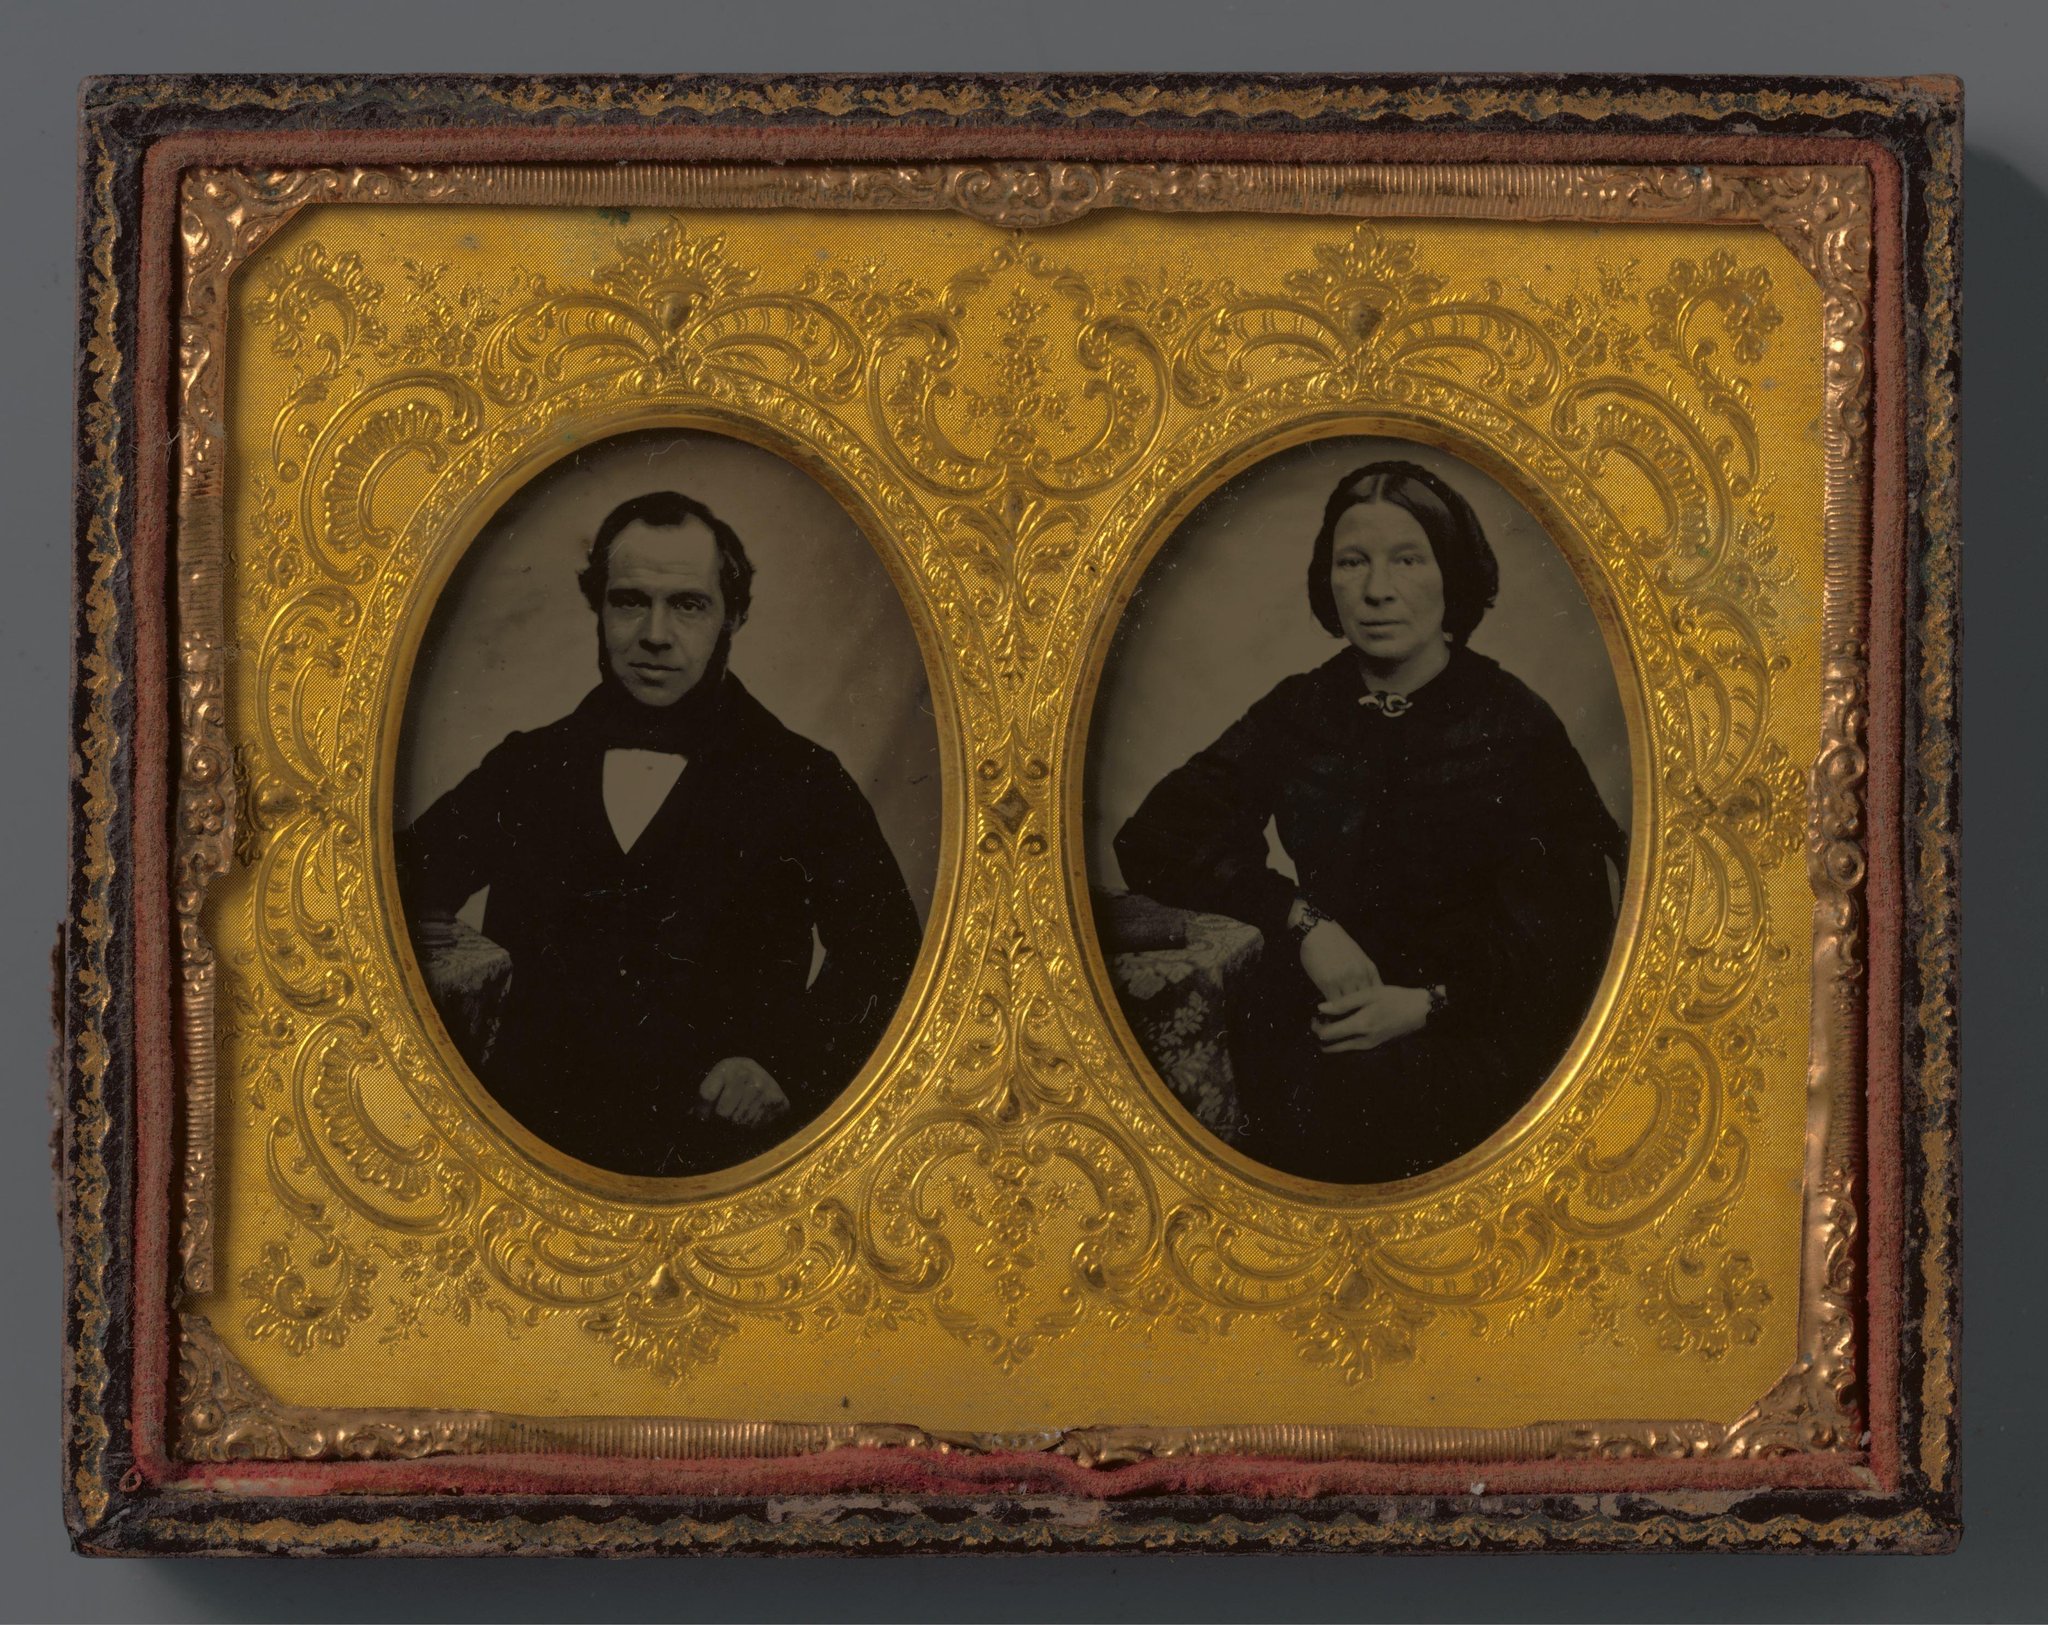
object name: frame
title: Portret van een onbekende man met bakkebaarden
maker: Anonymous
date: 1855-1870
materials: glass, leather, metal, textile, wood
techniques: ambrotype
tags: sideburns, historical persons